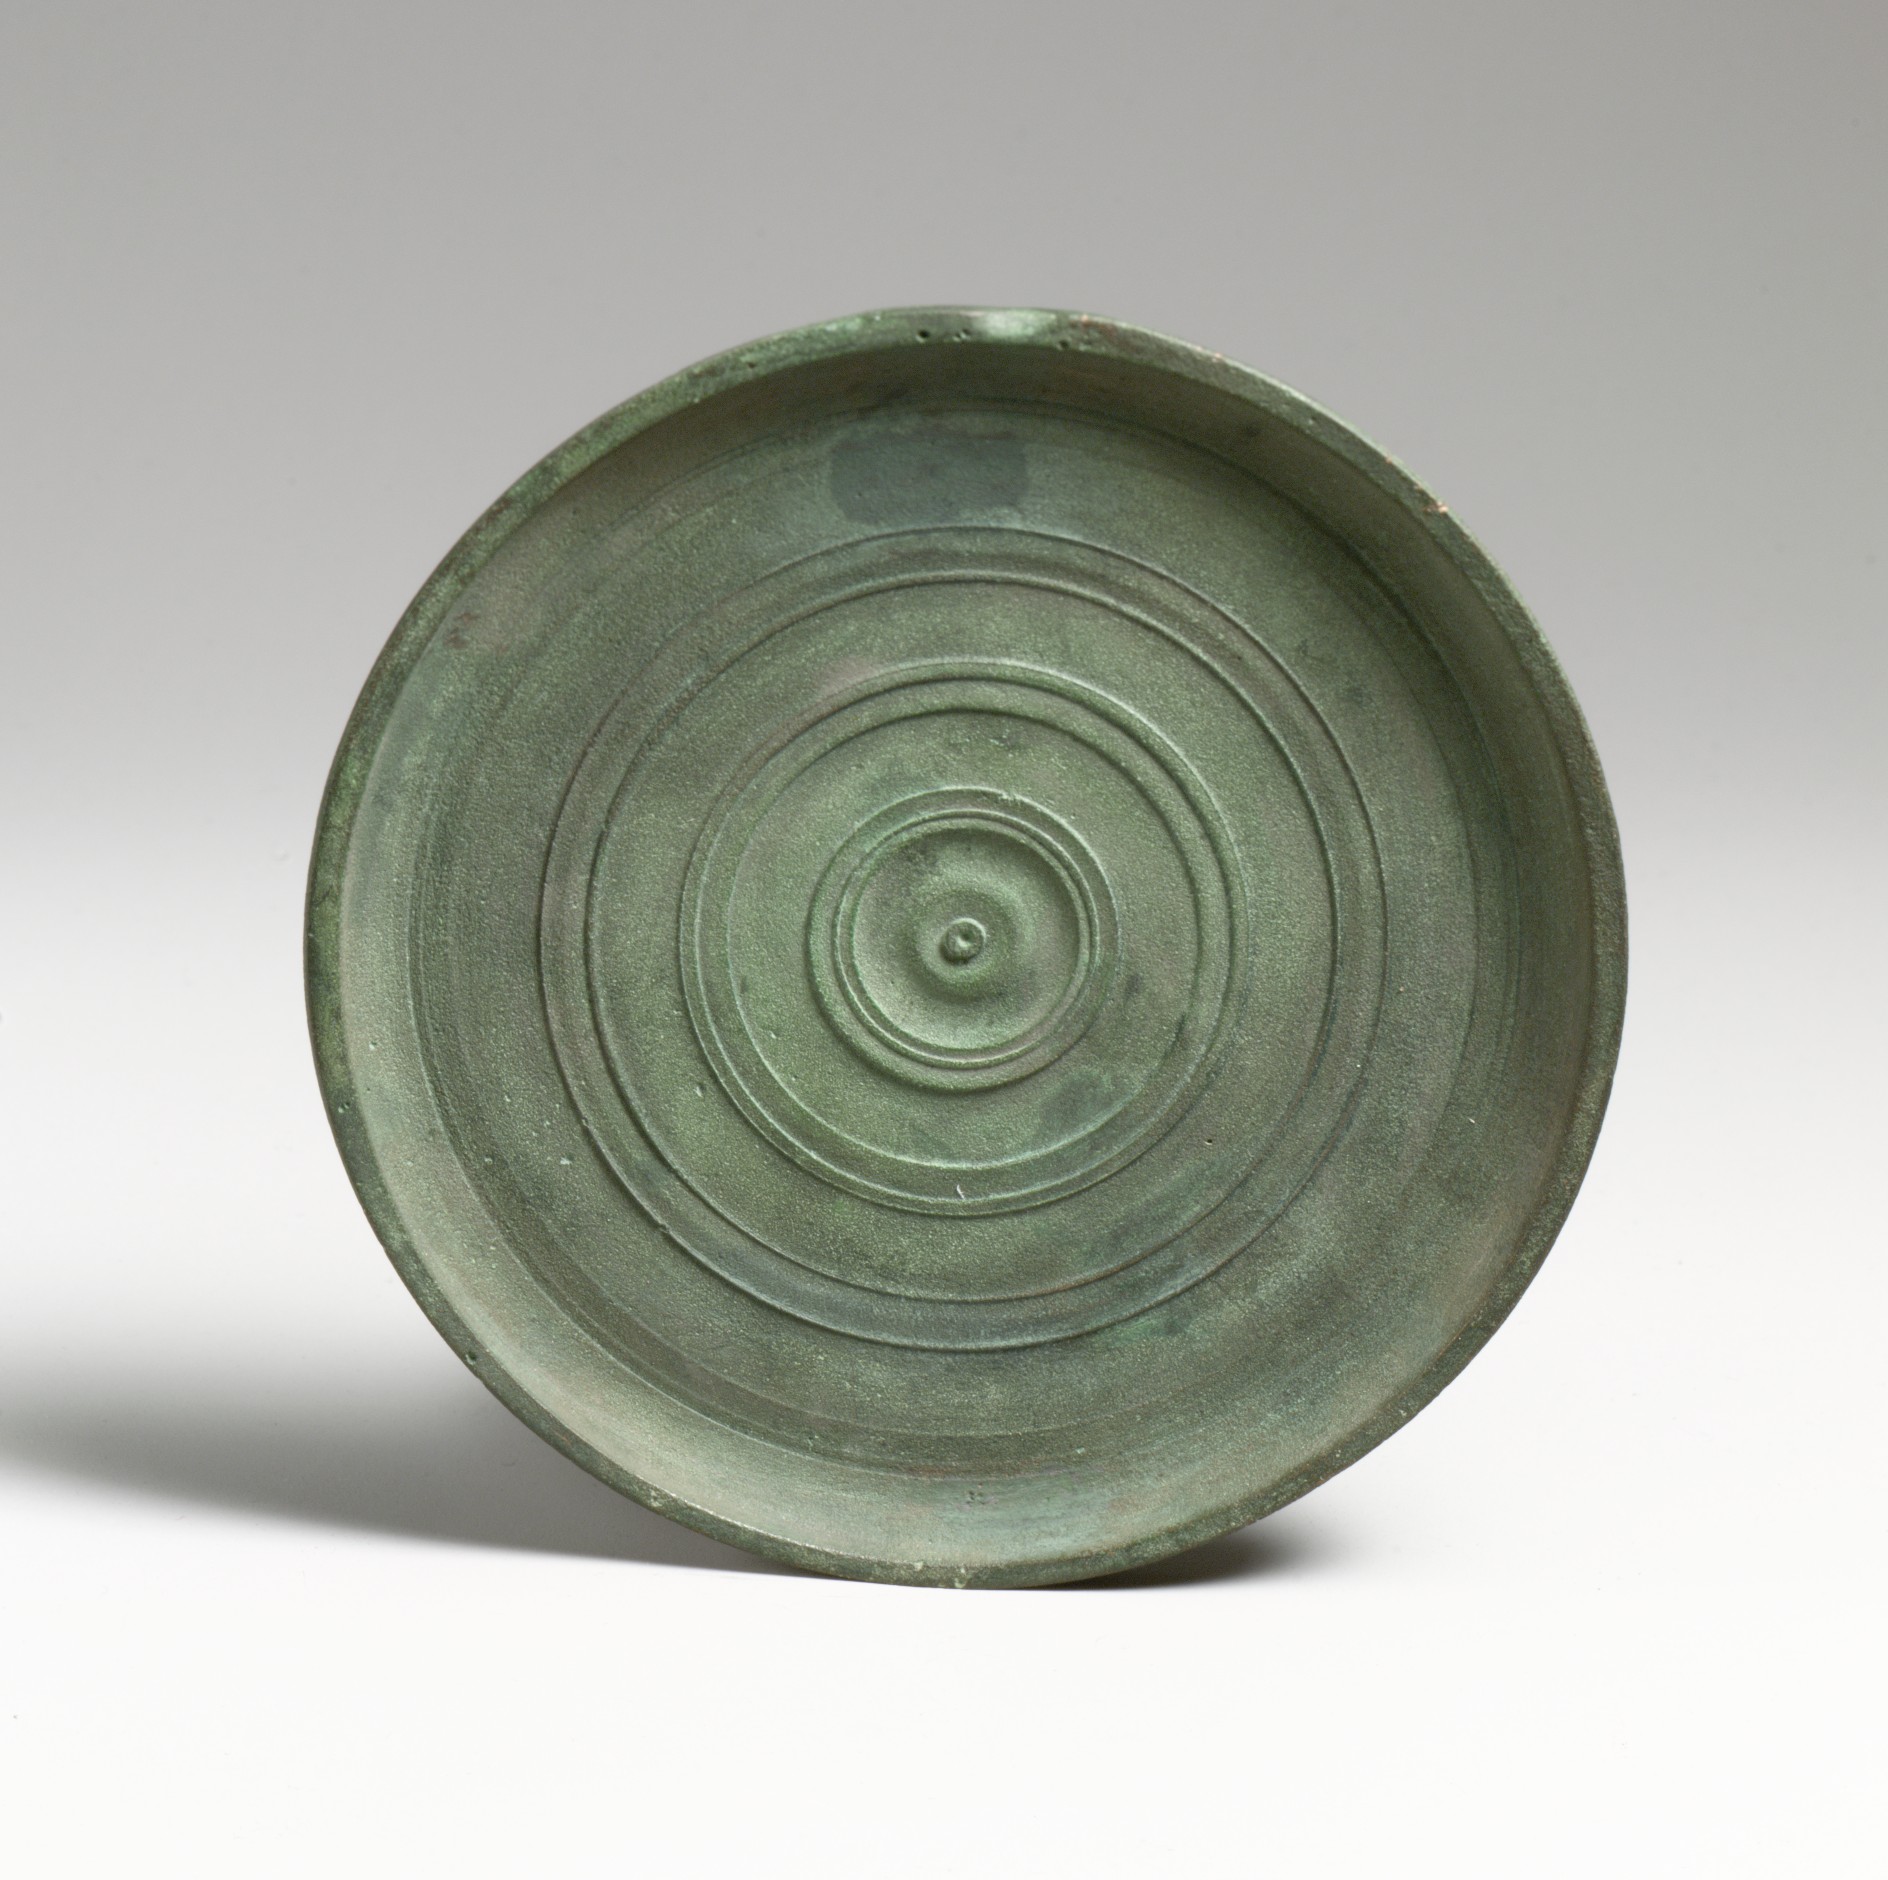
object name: mirror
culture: greek, cypriot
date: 7000-30 BCE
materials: bronze